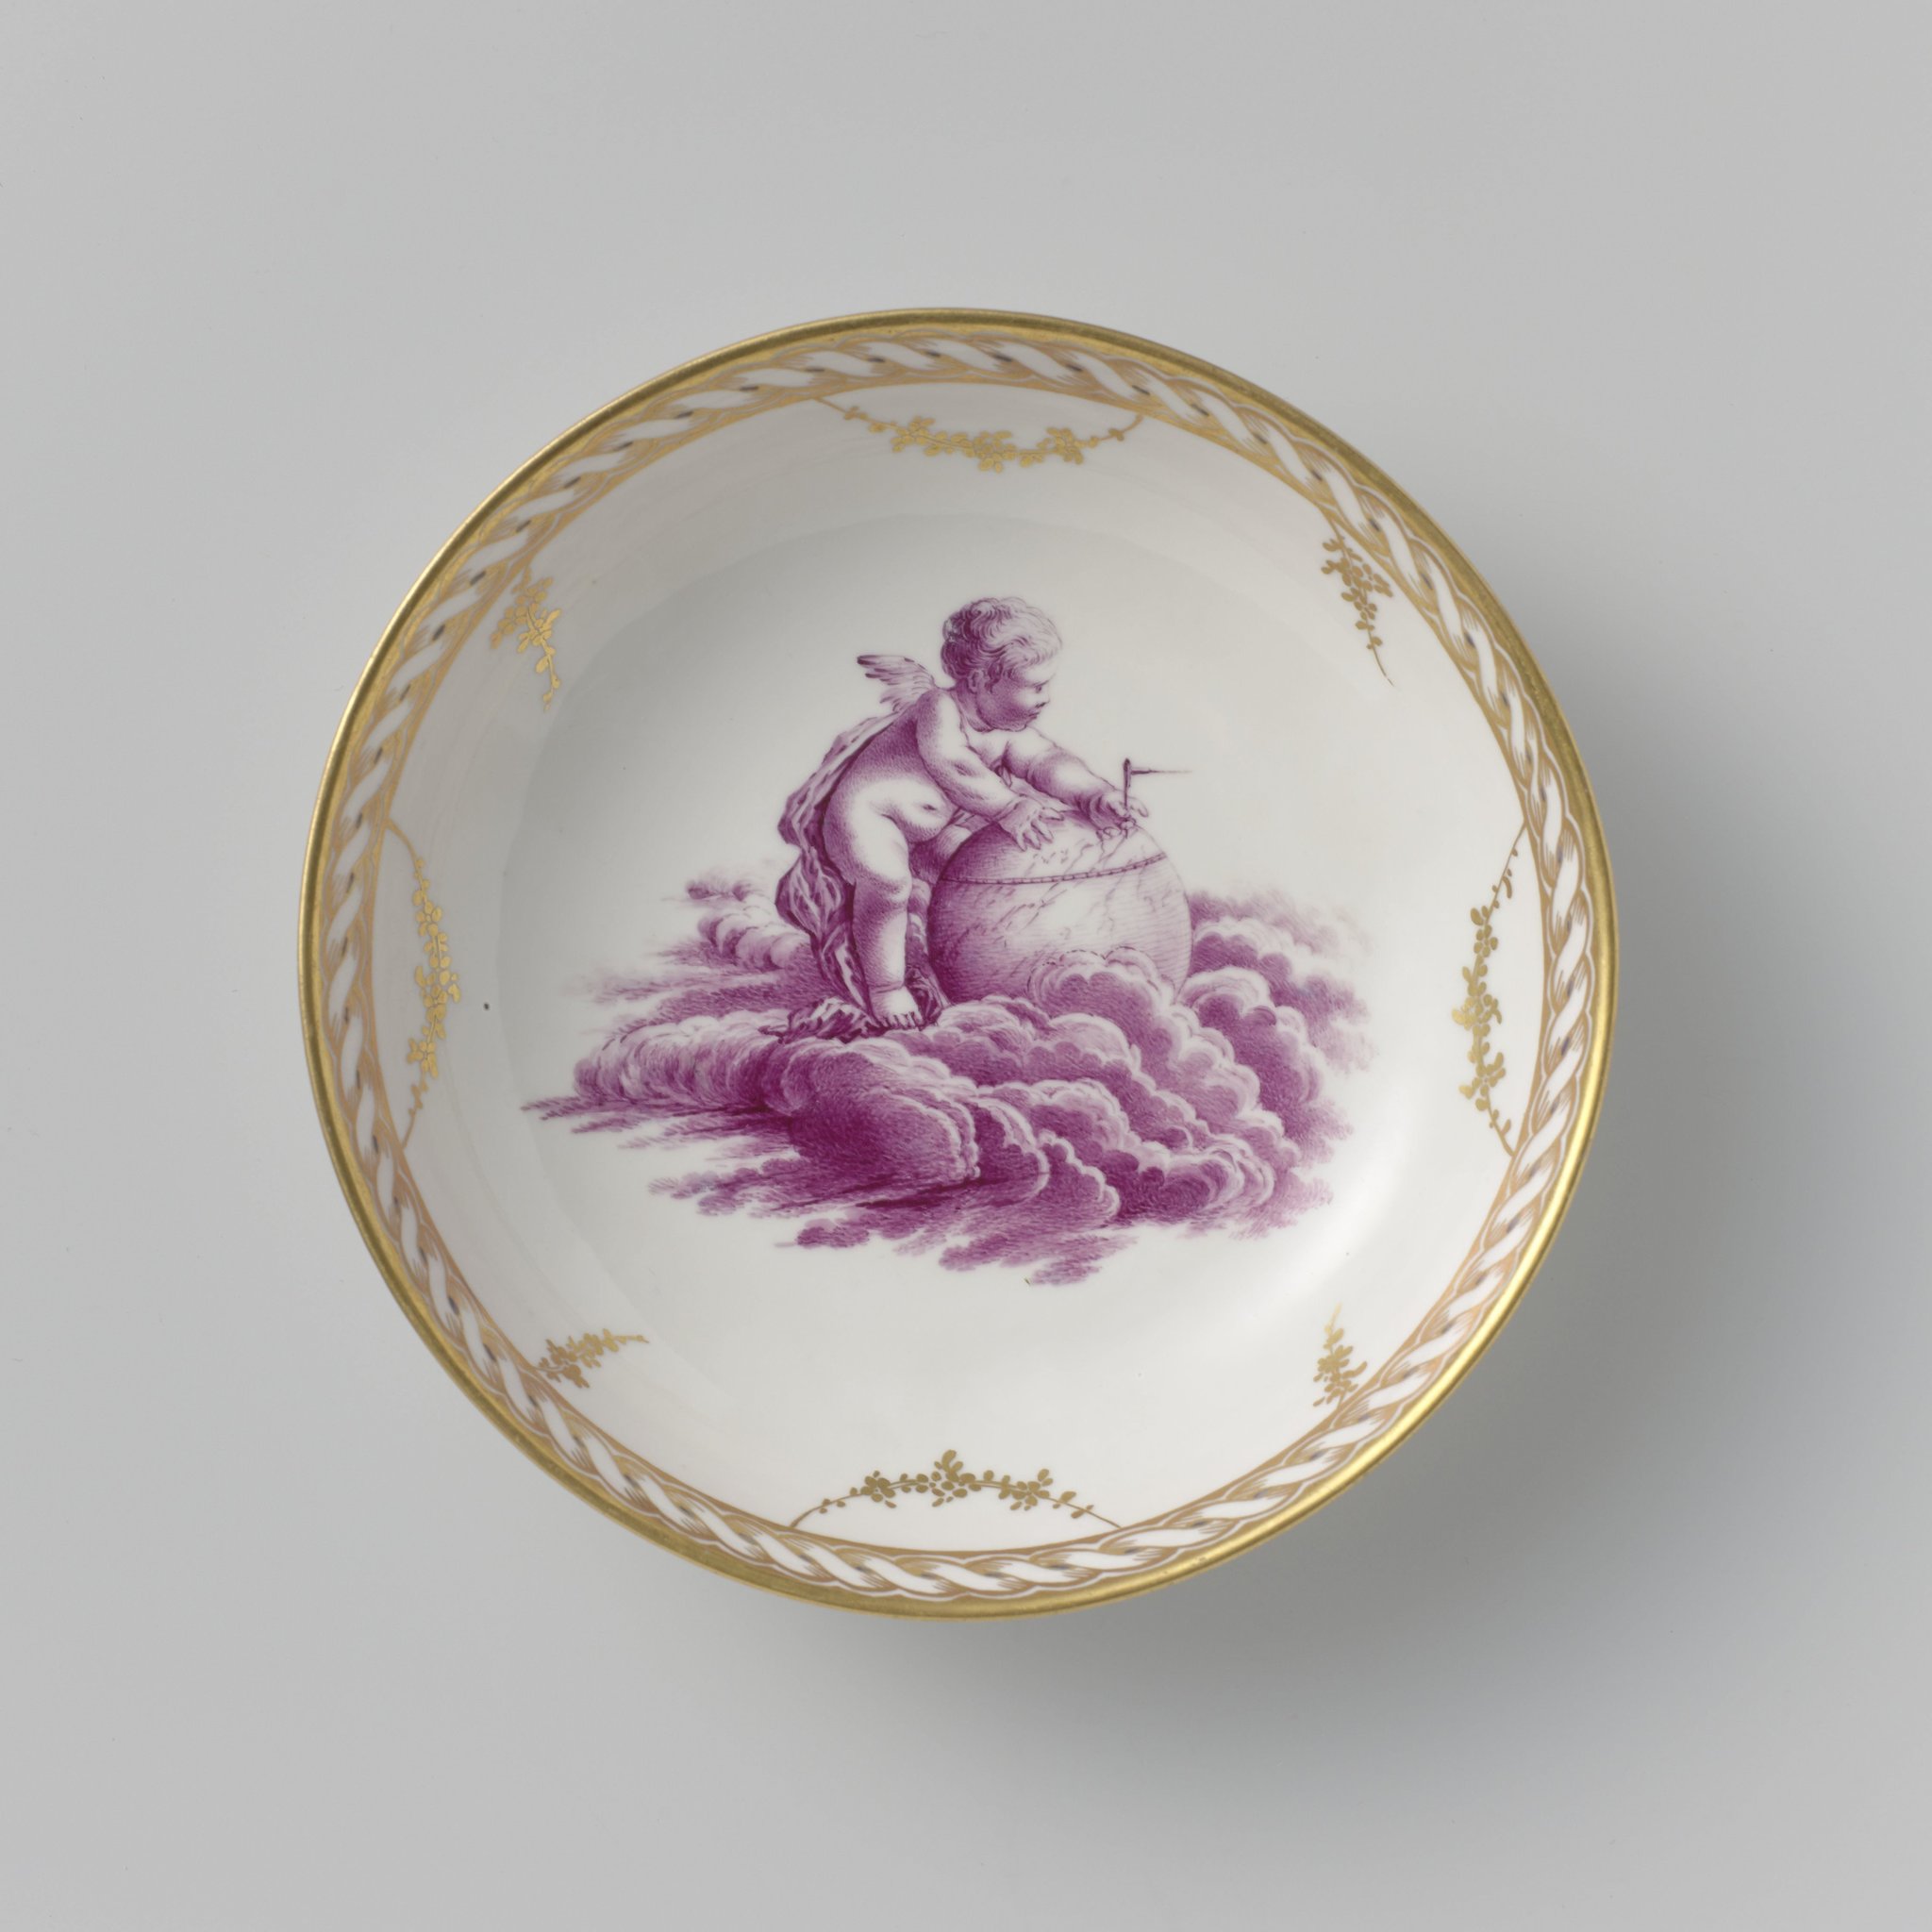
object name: service set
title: Saucer with a putto on clouds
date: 1785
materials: glaze, gold, paint, porcelain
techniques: firing, forming, gilding, turning, vitrification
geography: germany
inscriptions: mark: ‘ooievaar’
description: Schotel van porselein, beschilderd op het glazuur in roze (camaïeu) en goud. Op het plat een putto met een wereldbol en een passer op een wolk. De binnenrand met een gedraaide band, waaraan guirlandes en bloemtakken hangen. Gouden rand. Gemerkt op de onderzijde met de ooievaar.